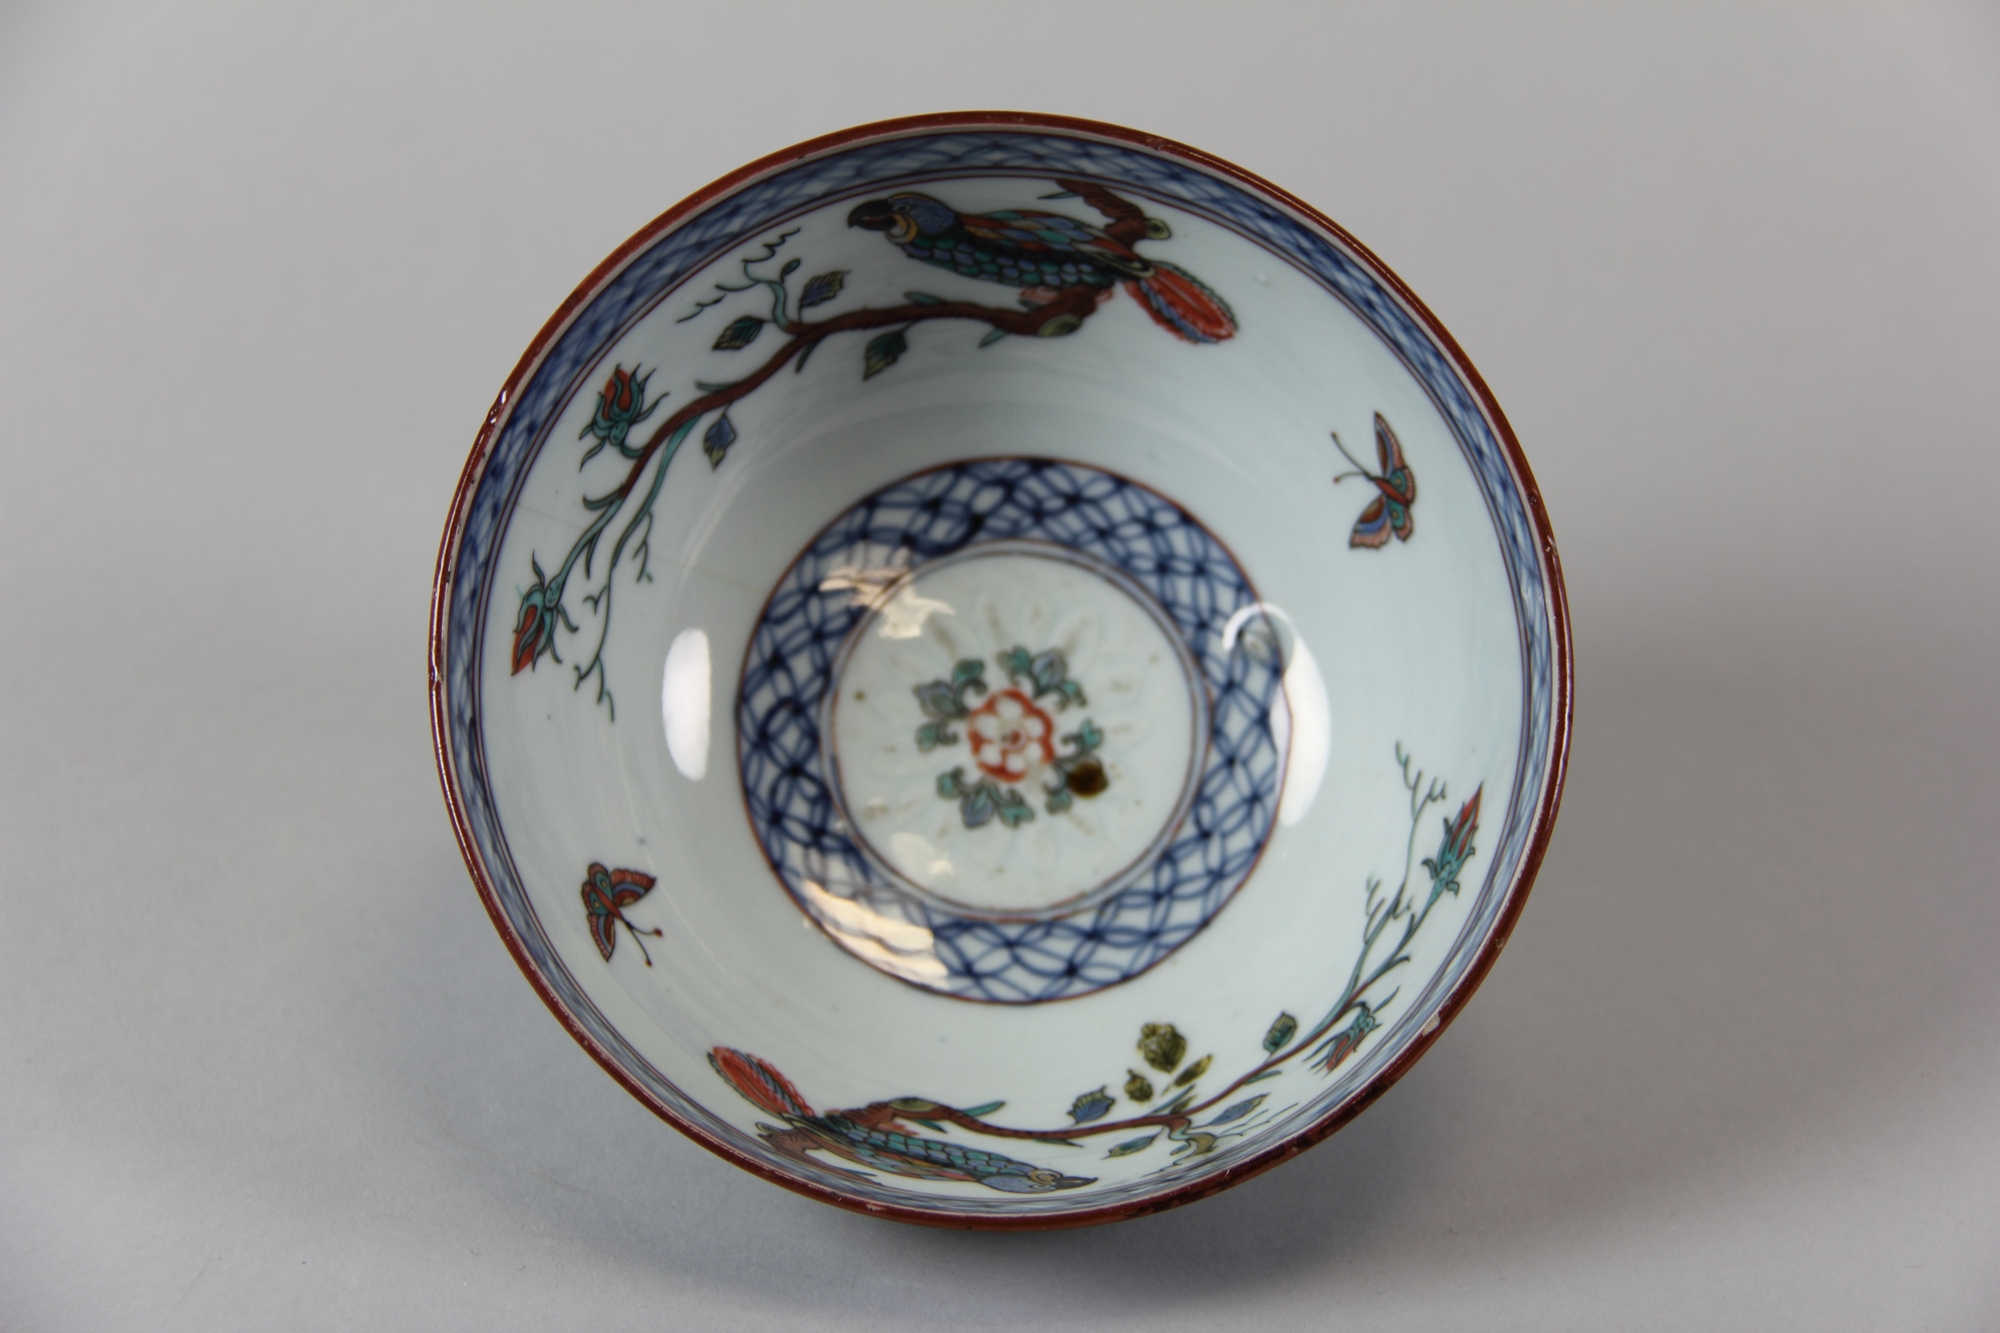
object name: bowl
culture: chinese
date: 1667-1733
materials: enamel, porcelain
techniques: overglaze, painting, polychrome, underglaze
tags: parrots,butterflies,flowers